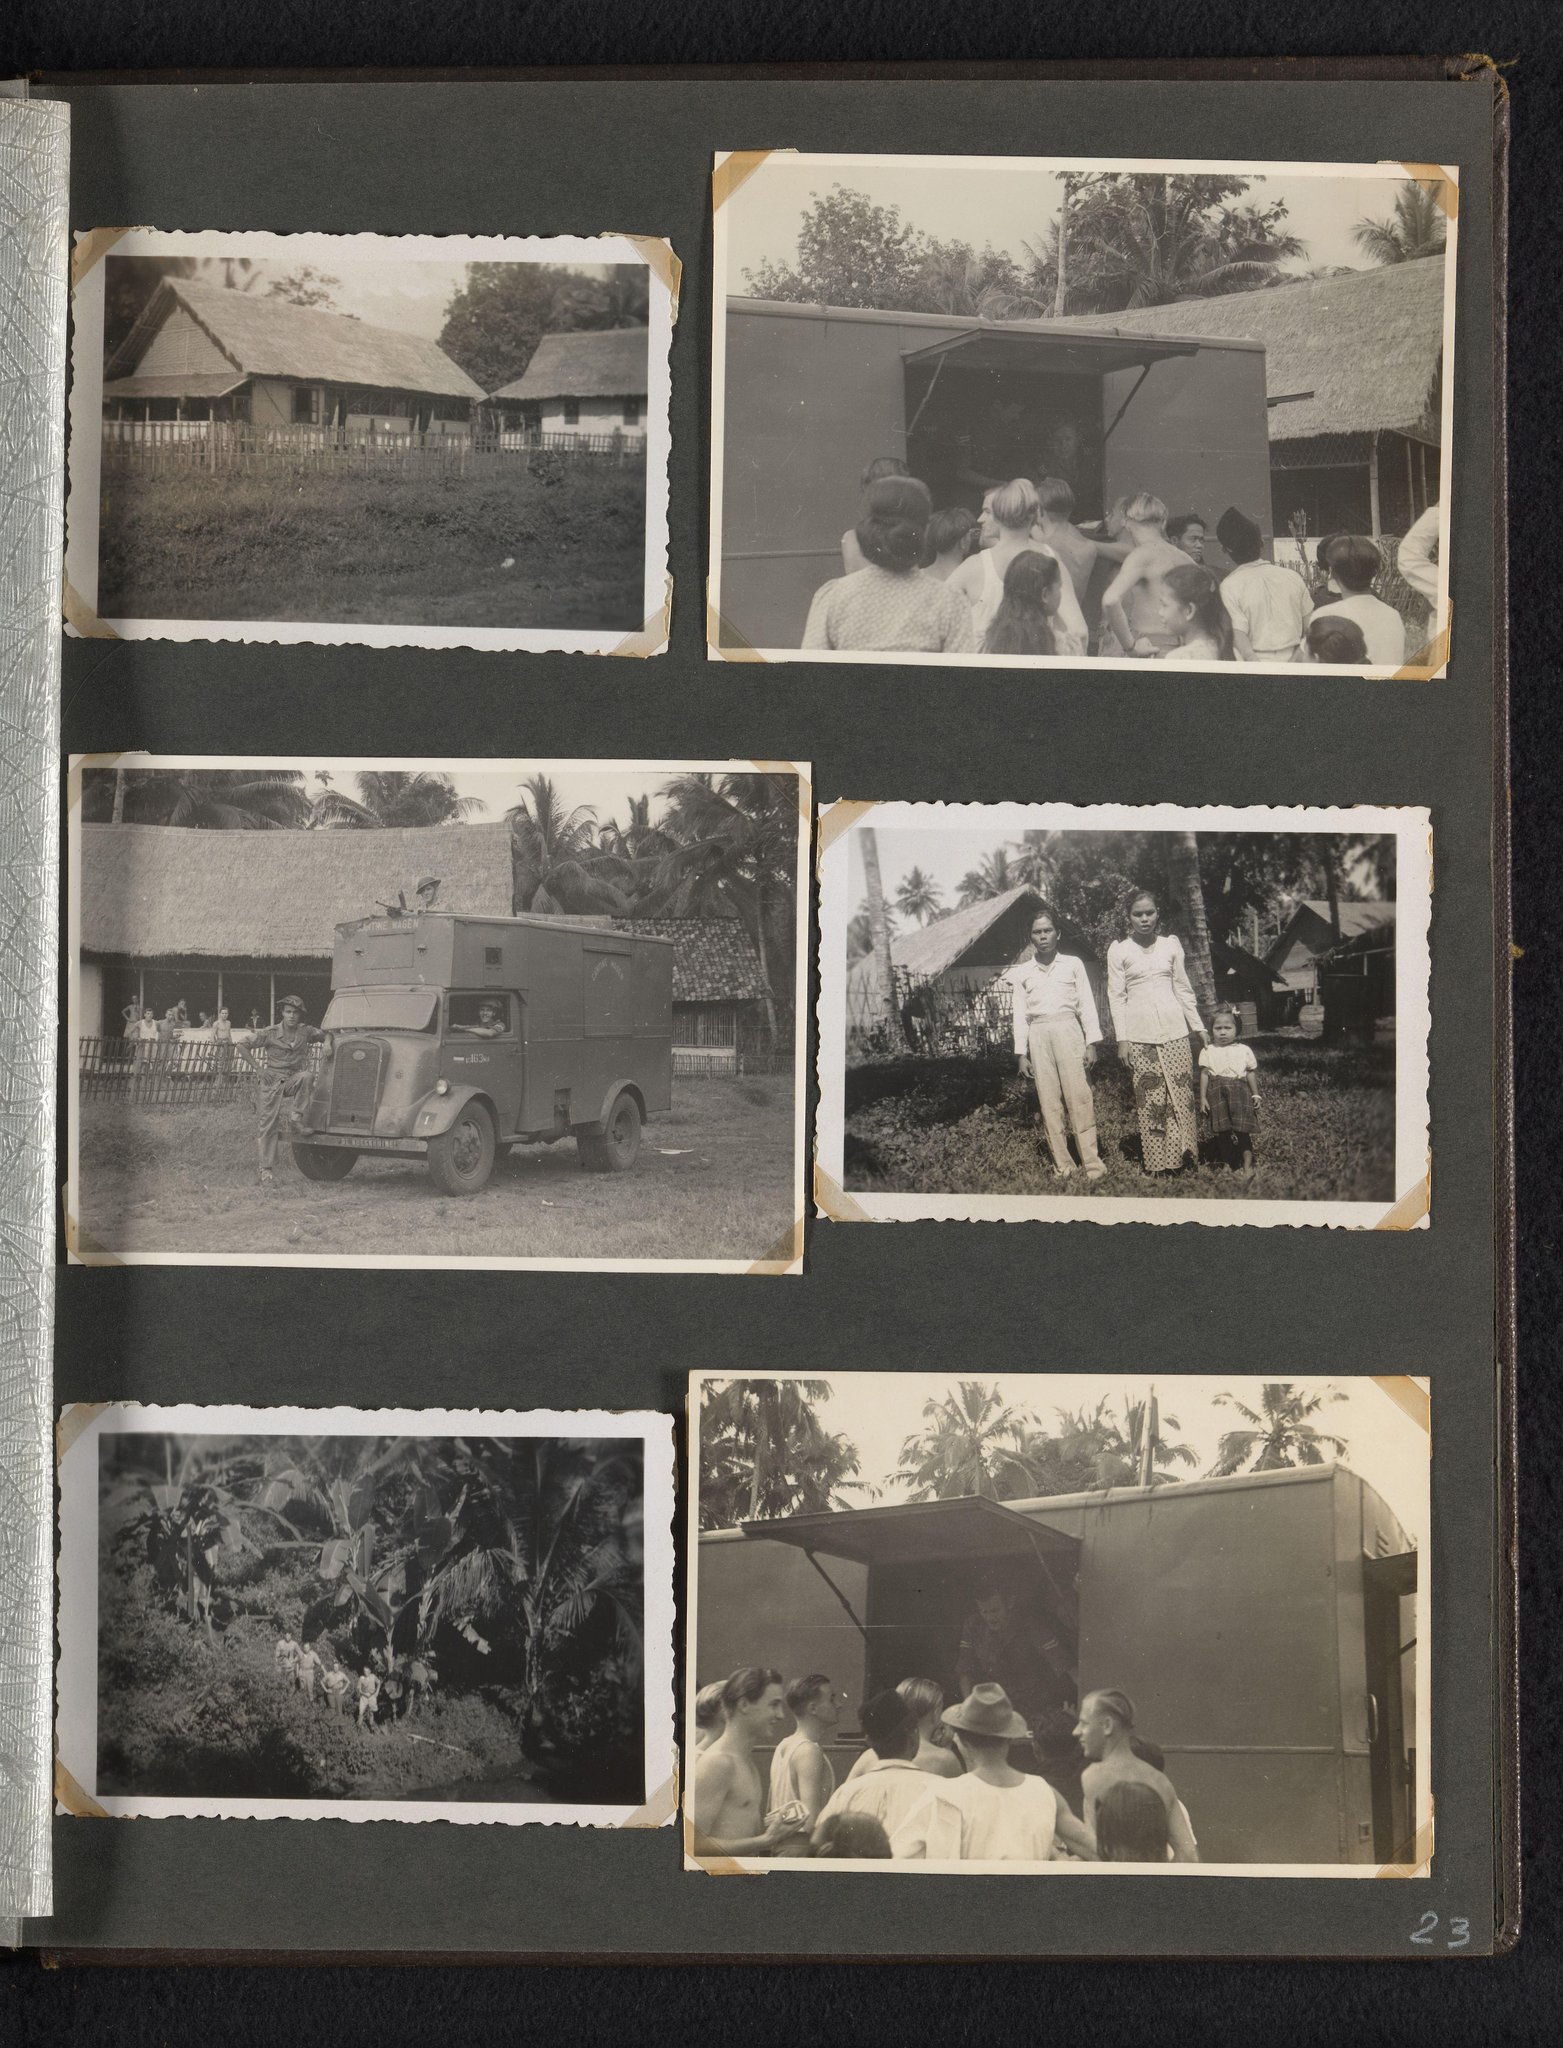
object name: photograph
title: Kamp en kantinewagen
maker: Anonymous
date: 1904-1949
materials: cardboard, photographic support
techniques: gelatin silver print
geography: dutch east indies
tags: the company, the unit, the troop ~ military service, canteen ~ the soldier off duty, barracks, dutch east indies, the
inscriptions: inscription: ‘Palembon / Keuken koelie met z'n vrouw, m'n baboe en dochter ... April '49’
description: Albumblad met zes foto's van het kamp van de Nederlandse militairen, Indonesisch personeel en van de kantinewagen, Palembon. Onderdeel van het fotoalbum 'Mijn jaren in Indië' met foto's over de militaire acties in Nederlands-Indië.